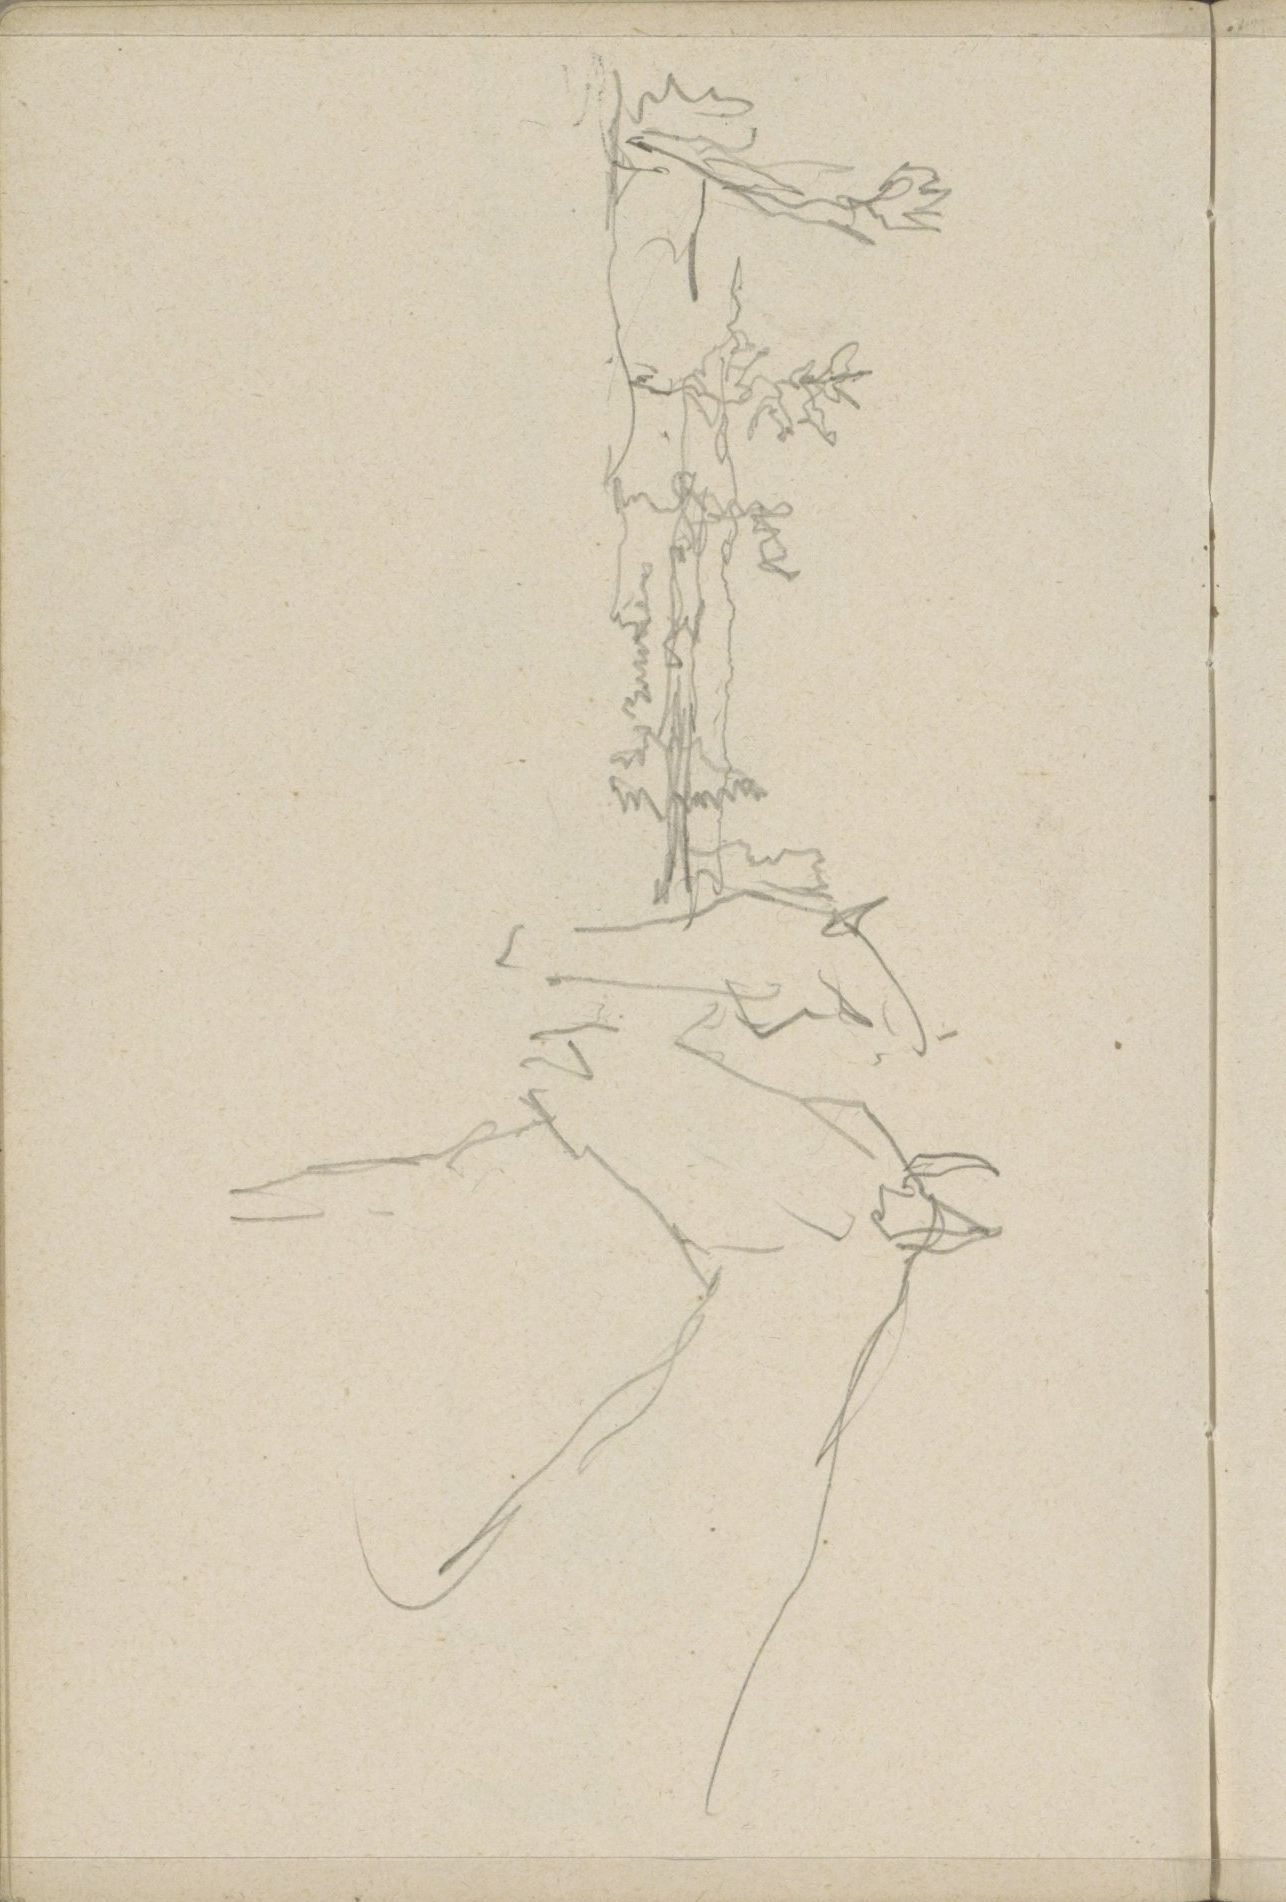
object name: sketchbook leaf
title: Landschap met twee paarden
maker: george hendrik breitner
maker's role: draughtsman, painter, print maker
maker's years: 1857-1923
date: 1914-1923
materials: paper, pencil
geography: north holland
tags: landscapes, horse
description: Landschap met twee paarden. Pagina 63 uit een schetsboek met 43 bladen vervaardigd te Amsterdam.